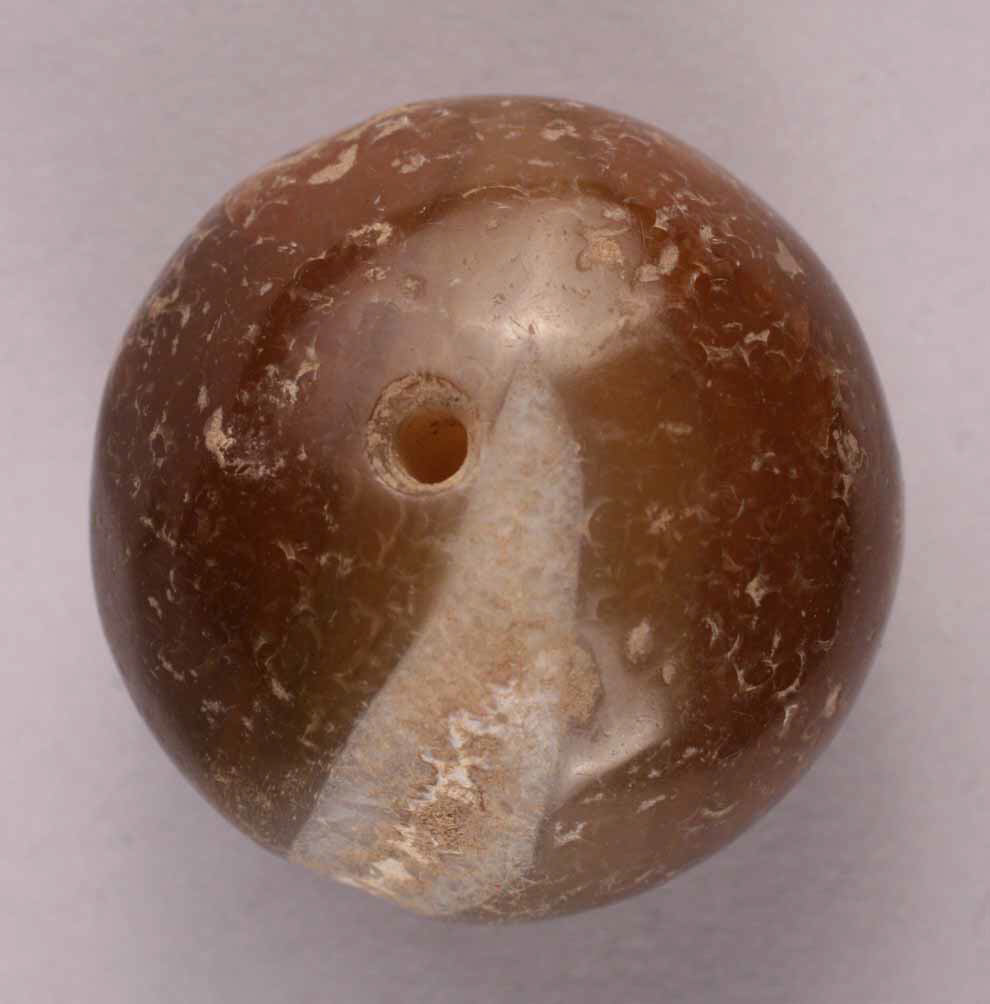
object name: bead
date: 701-1300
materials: stone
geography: iran